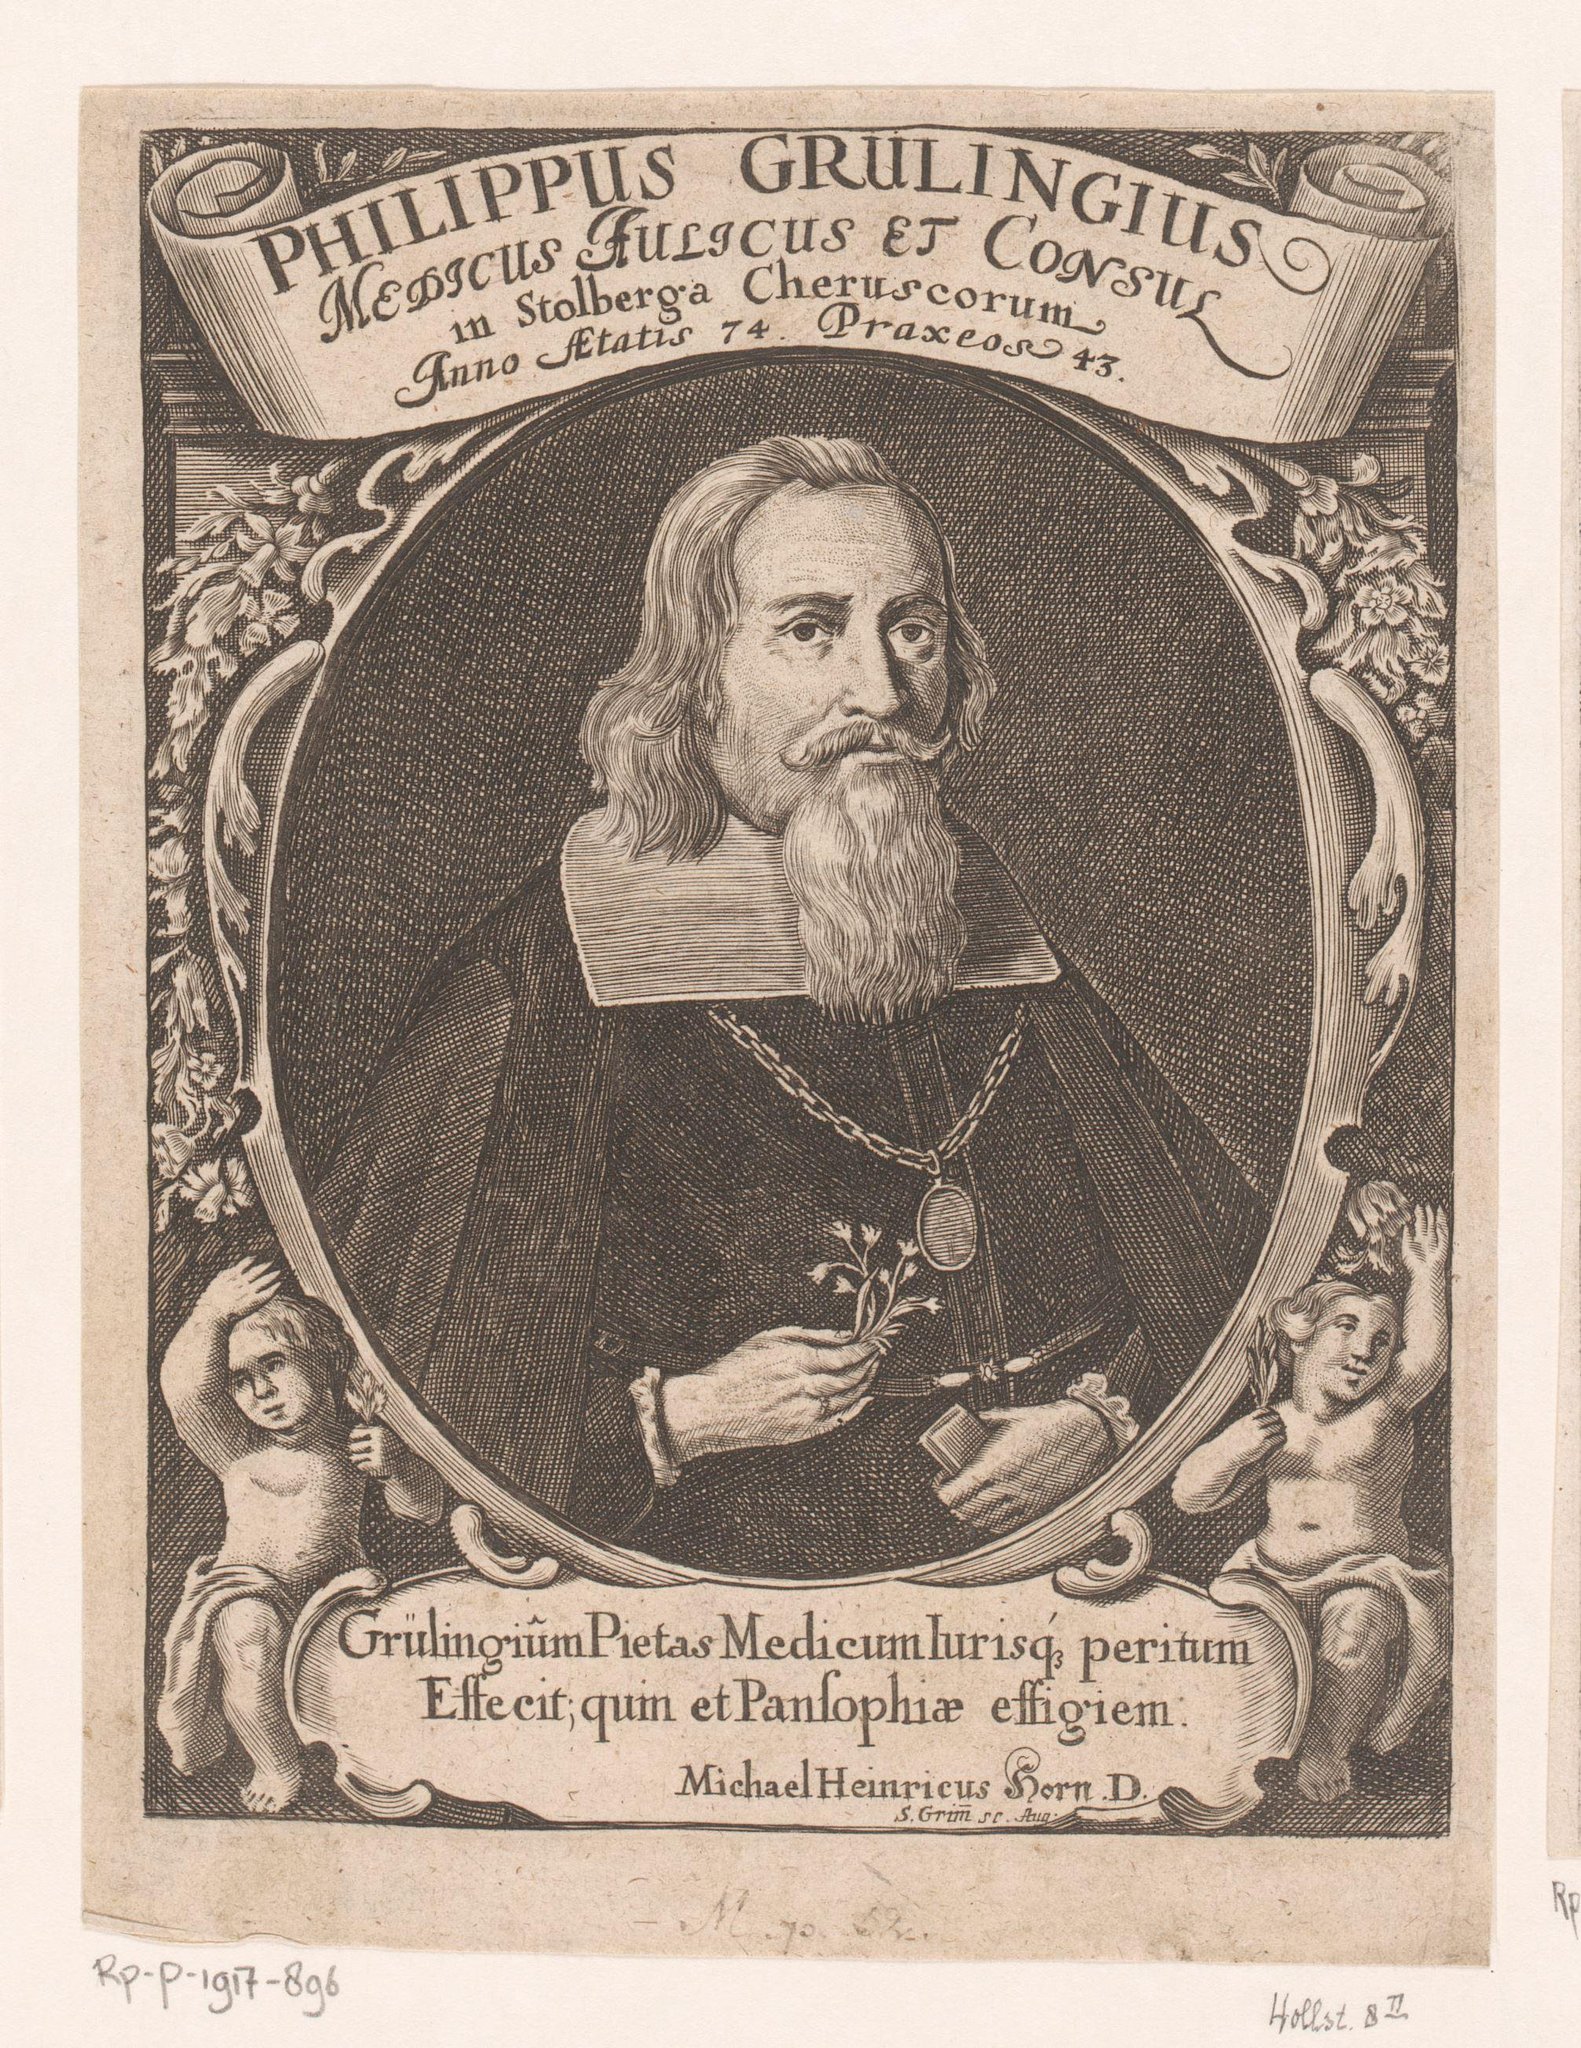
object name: print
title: Portret van Philipp Gerhard Grueling op 74-jarige leeftijd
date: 1667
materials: paper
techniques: engraving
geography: augsburg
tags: flowers, historical persons, pendant, trinket, 'breloque', physician, doctor, ornament ~ festoon, garland, cupids: 'amores', 'amoretti', 'putti'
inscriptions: collector's mark: Lugt 2228